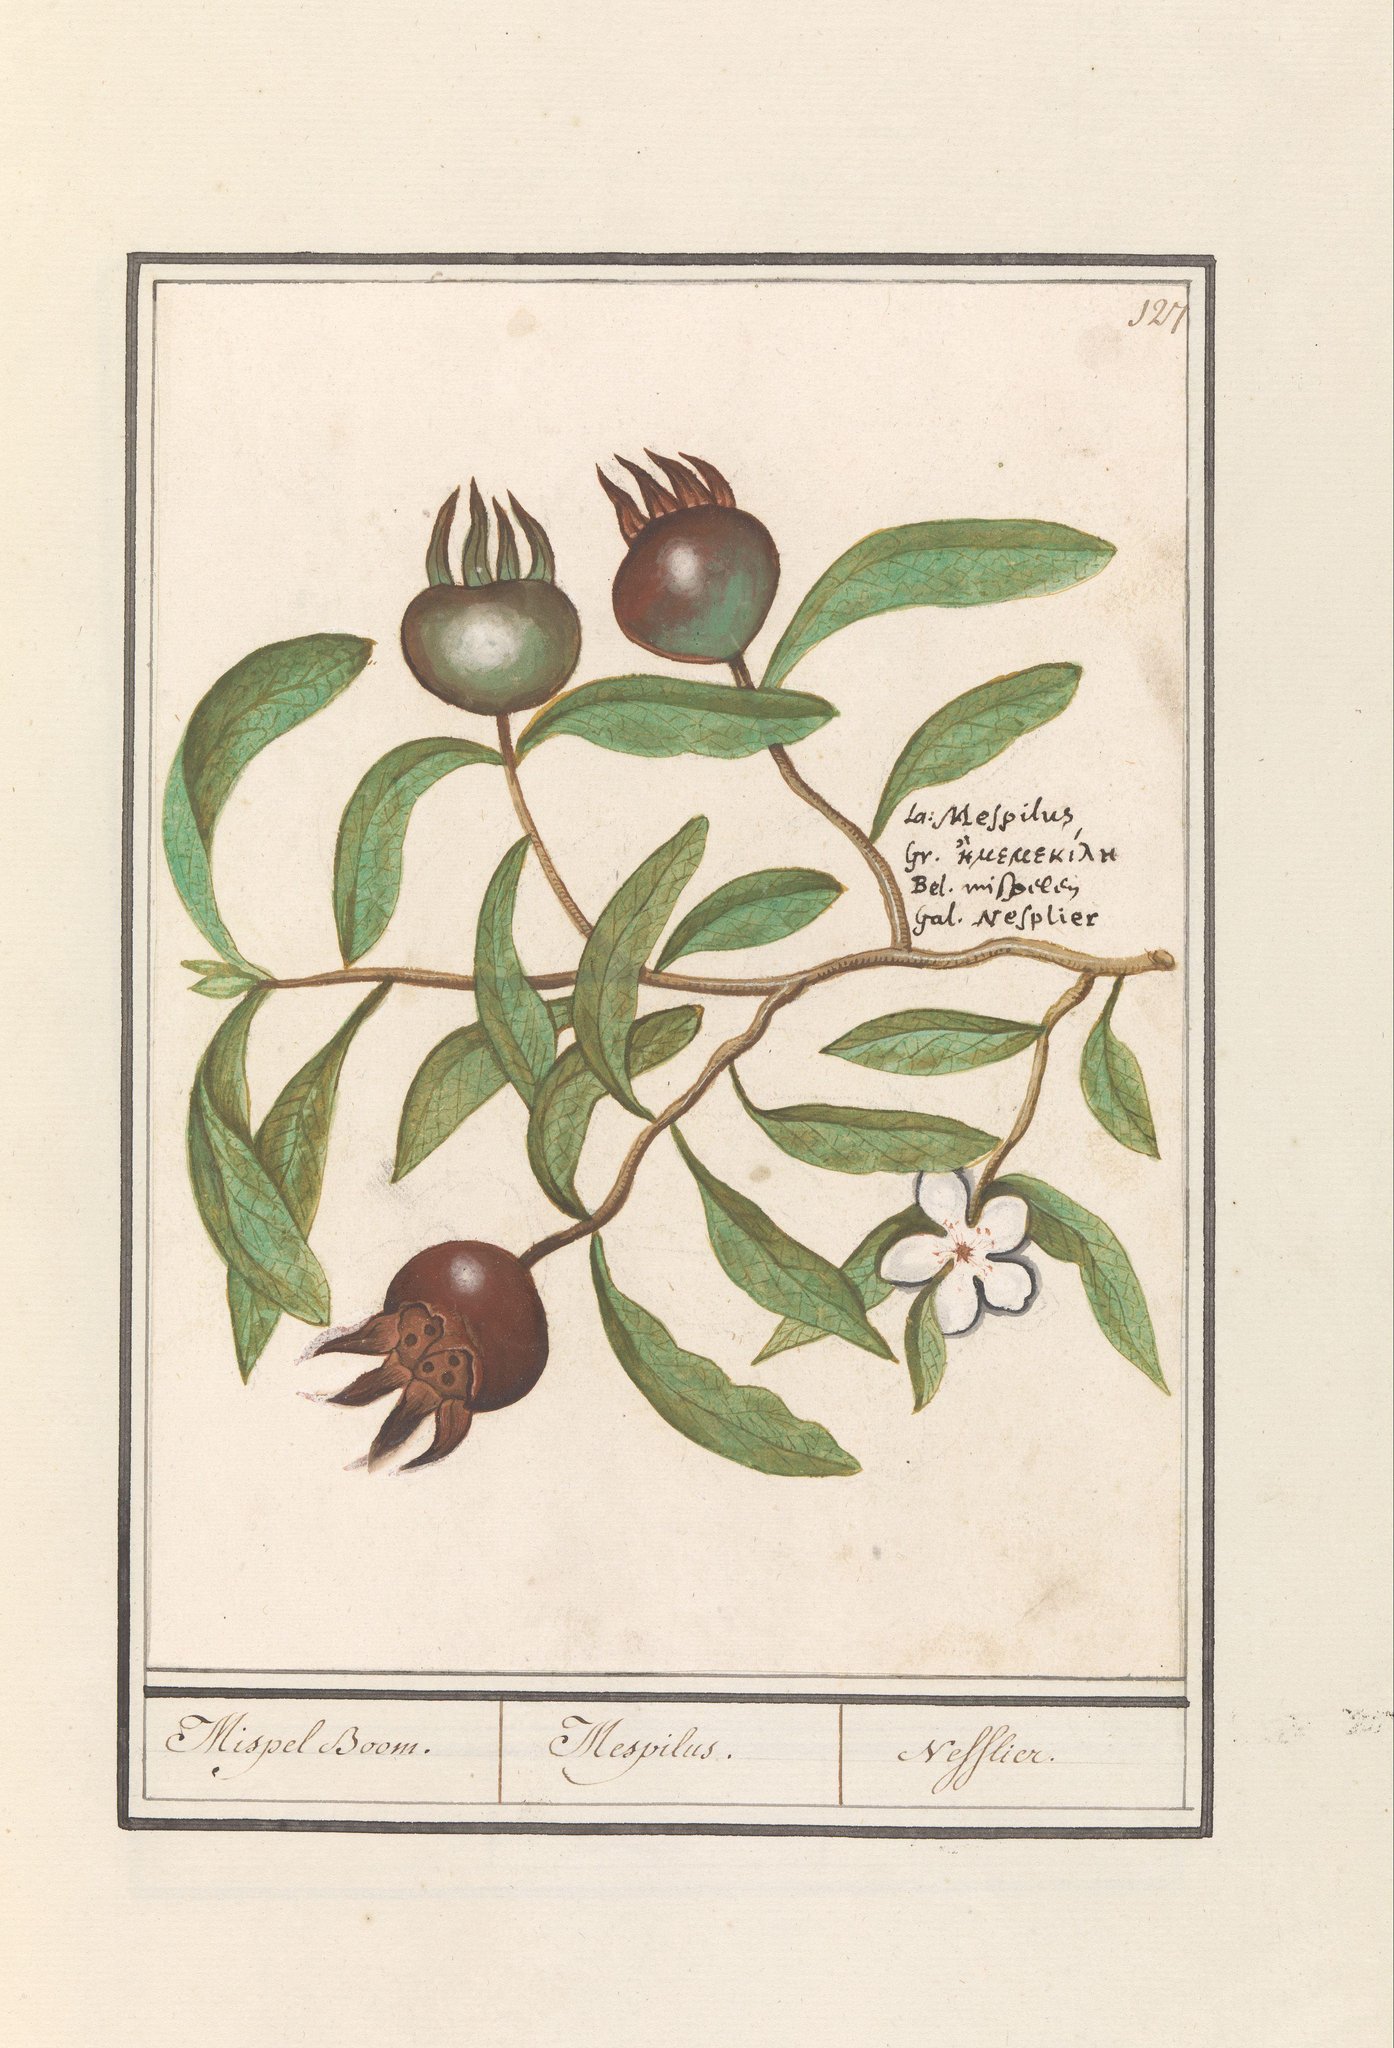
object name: drawing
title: Mispel (Mespilus germanica)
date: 1596-1610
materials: chalk, paint, ink, paper, watercolor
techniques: brush, pen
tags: fruits: medlar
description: Mispel, tak met bladeren, bloem en vruchten. Rechtsboven genummerd: 127. Rechts de naam in vier talen. Onderdeel van het tweede album met tekeningen van bloemen en planten. Negende van twaalf albums met tekeningen van dieren, vogels en planten bekend rond 1600, gemaakt in opdracht van keizer Rudolf II. Met toelichting in Nederlands, Latijn en Frans.